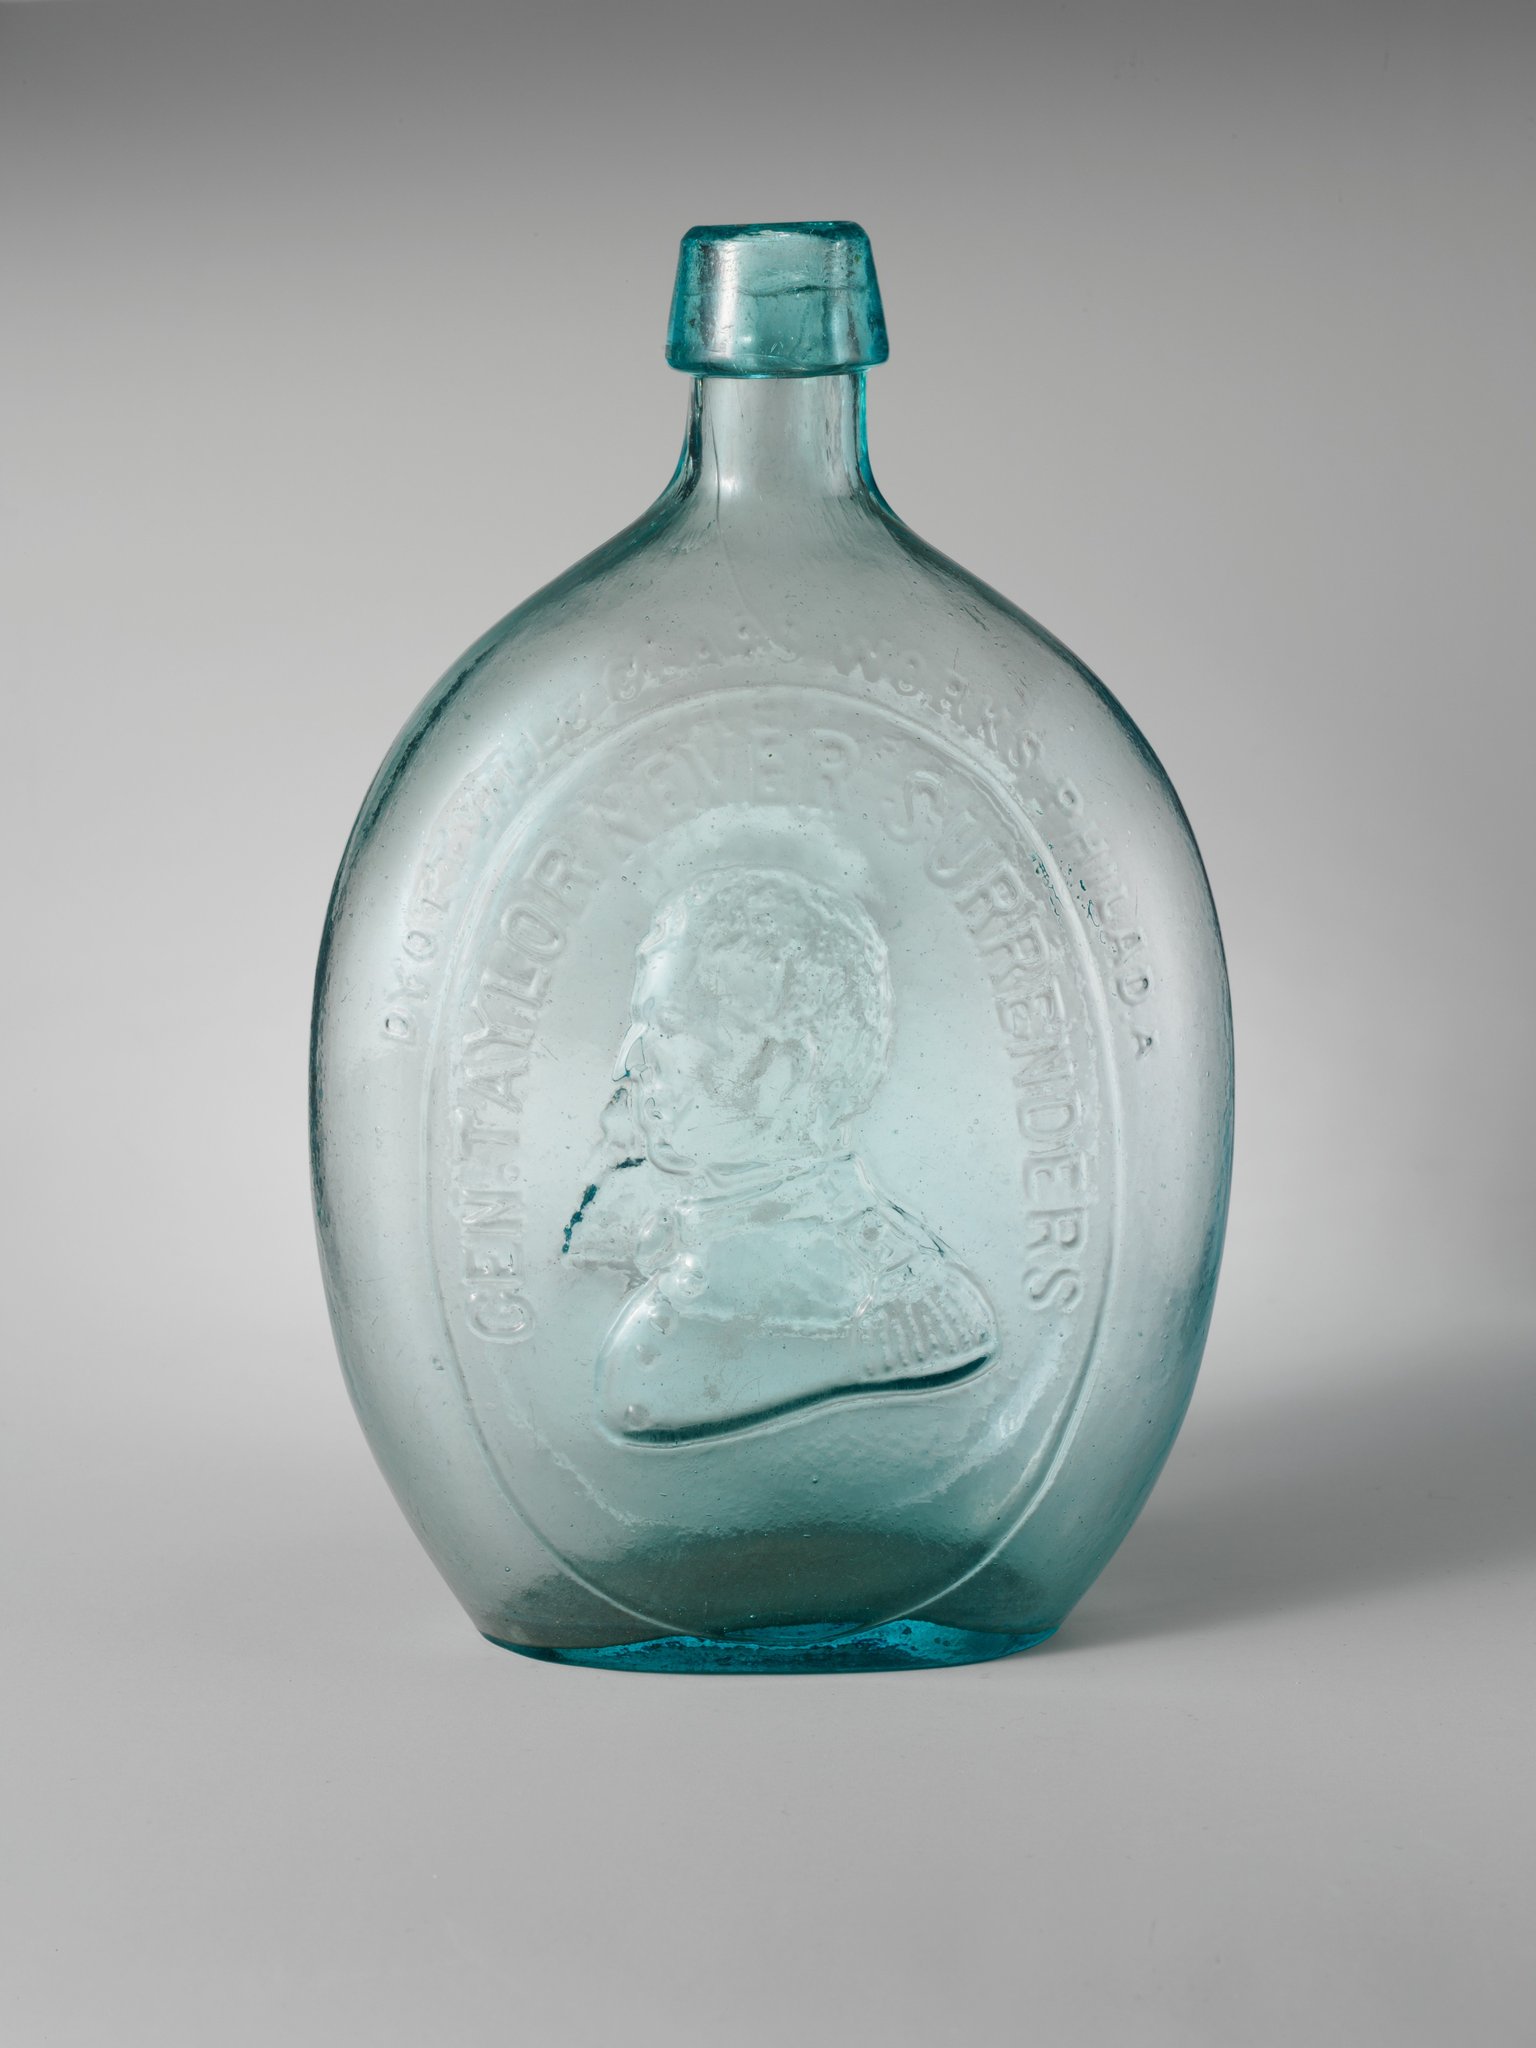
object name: flask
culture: american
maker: dyottville glass works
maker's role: maker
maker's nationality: american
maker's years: 1833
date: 1847-1848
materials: gemstone, glass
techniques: glassblowing, molding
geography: united states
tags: george washington,men,profiles